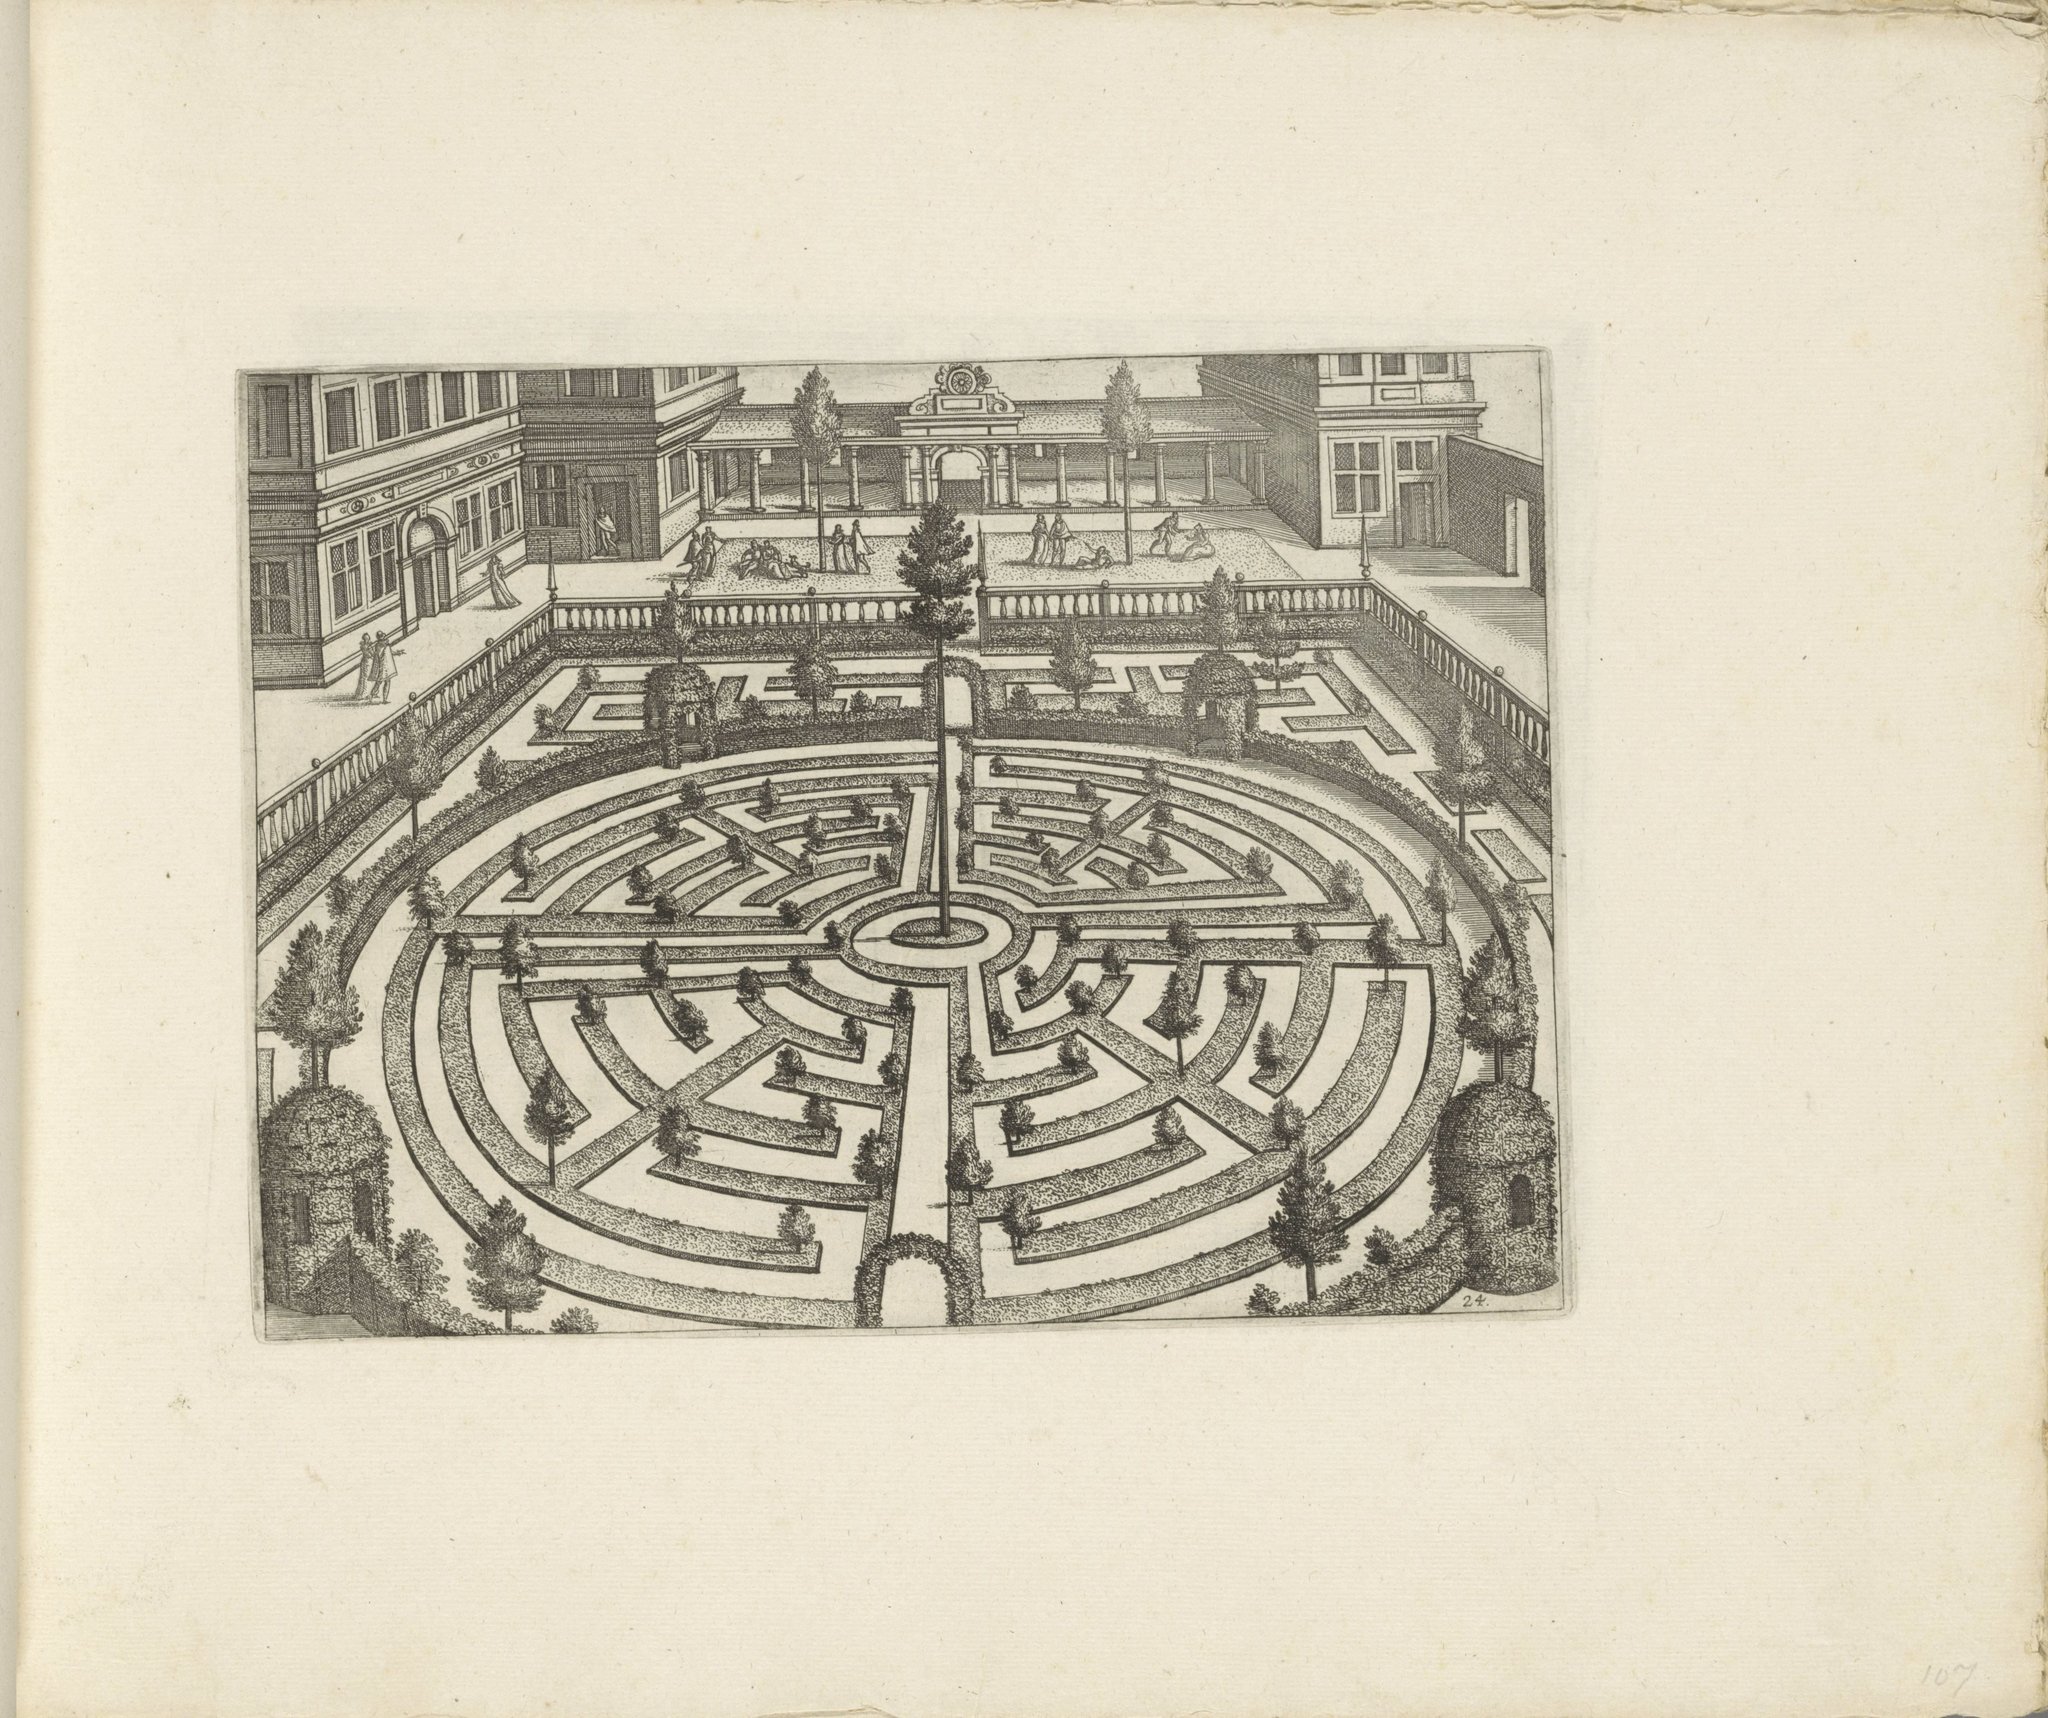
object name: print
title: Cirkelvormige parterre in de vorm van een labyrint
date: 1587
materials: paper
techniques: etching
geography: antwerp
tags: garden, french or architectonic garden; formal garden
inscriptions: collector's mark: Lugt 2228, collector's mark: Lugt 2760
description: De serie ‘Hortorum Viridariorumque’ van Vredeman de Vries (Hollstein Dutch 470-490) is in deze editie van de serie door uitgever Joannes Galle ( en eerder door zijn voorganger Theodoor Galle) aangevuld met de serie ‘Tuinen’ van Vredeman de Vries (Hollstein Dutch 508-515) en met twee prenten van Pieter van der Borcht (I) (New Hollstein Dutch 161-162). De prenten zijn genummerd: 1-30. Origineel hoort bij deze editie van de serie, uitgegeven door Joannes Galle, nog een prent van Van der Borcht met nummer 31, maar deze prent ontbreekt in deze serie in de collectie van het Rijksmuseum.